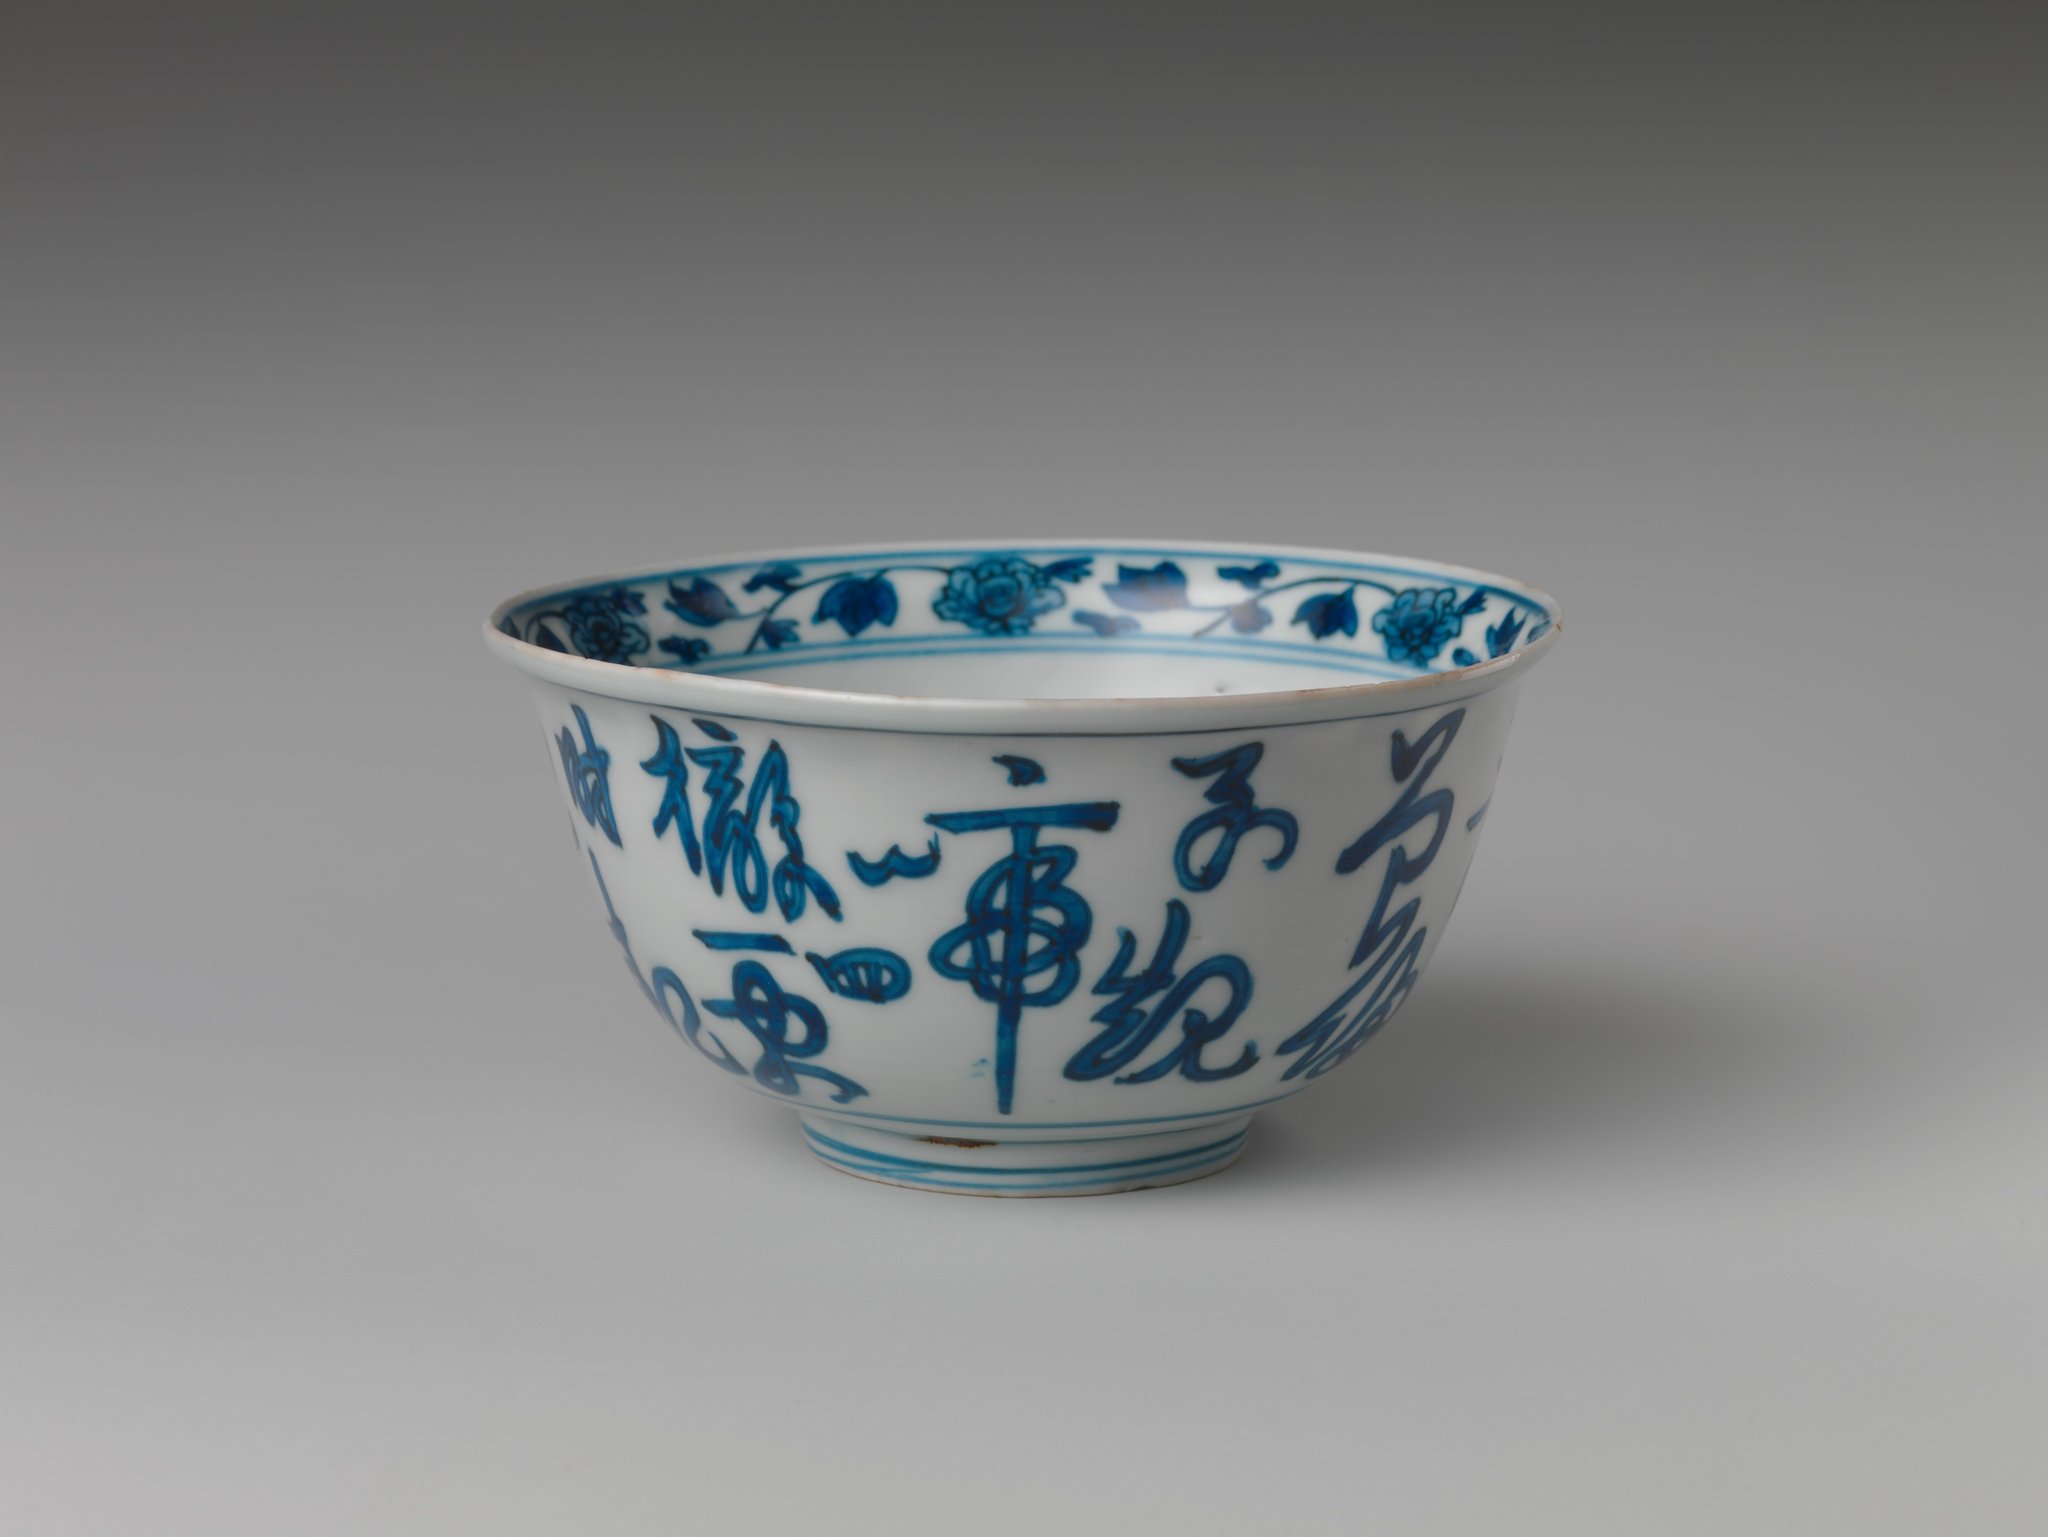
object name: bowl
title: Bowl with inscription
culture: chinese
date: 1567-1600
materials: cobalt, porcelain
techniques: painting, underglaze